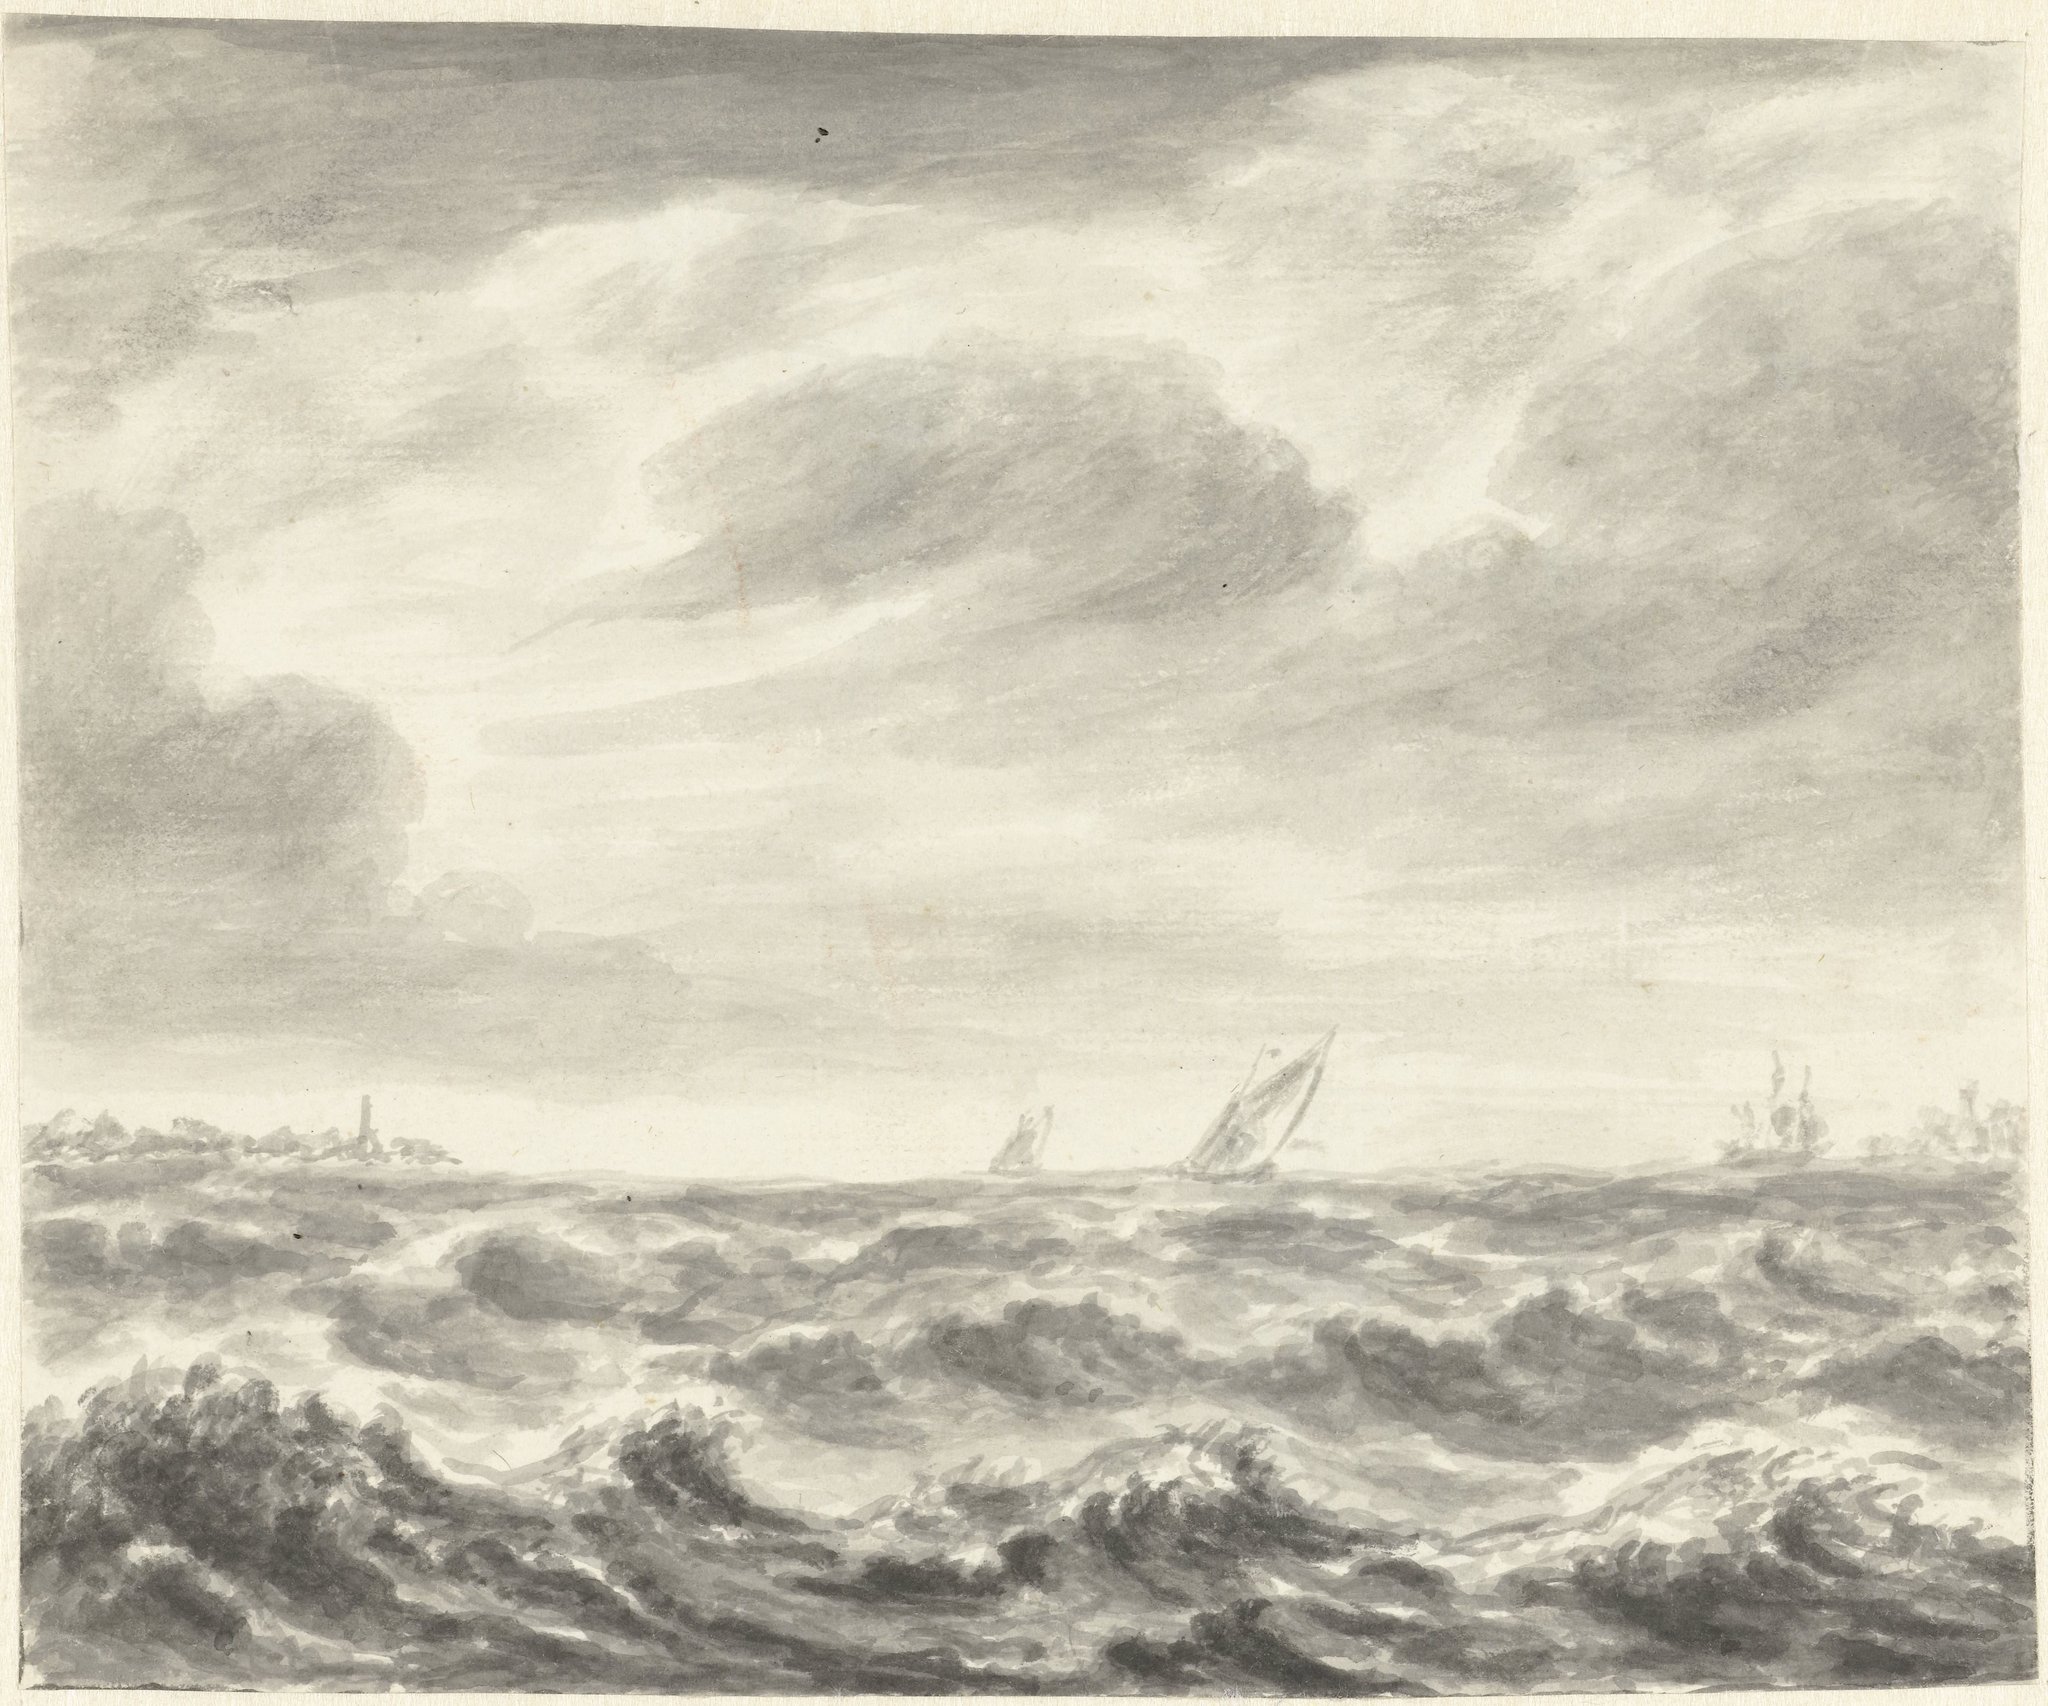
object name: drawing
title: Zeegezicht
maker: pieter idserts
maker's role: draughtsman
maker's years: 1698-1781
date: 1708-1781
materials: paper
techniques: brush